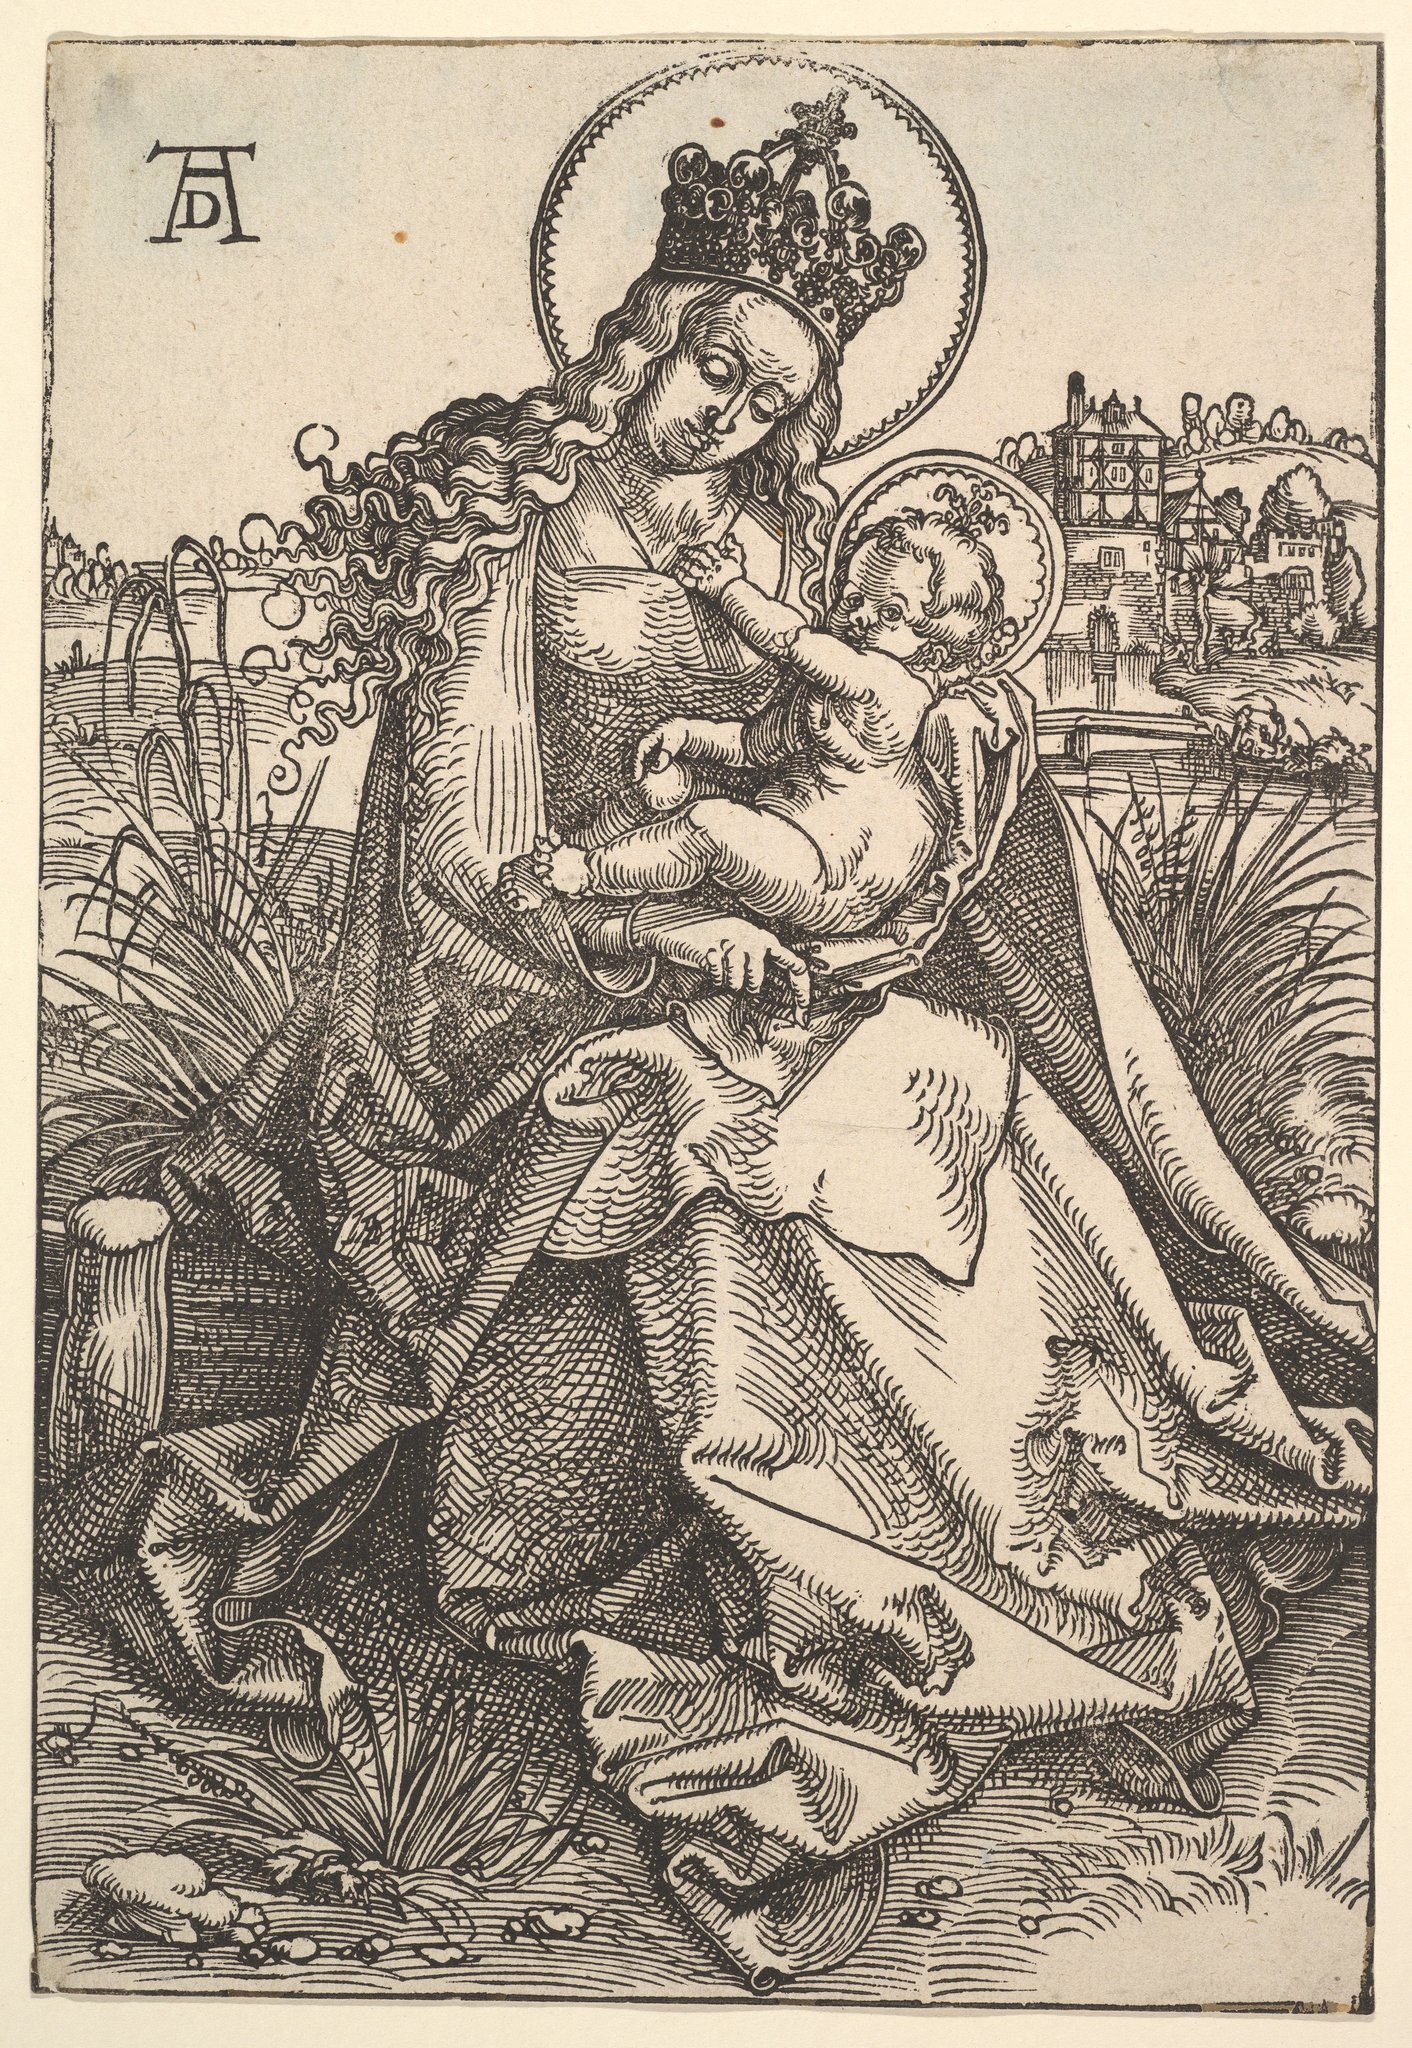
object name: print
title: The Virgin on the Grassy Bank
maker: hans baldung (called hans baldung grien)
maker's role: artist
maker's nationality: german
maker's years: 1484-1545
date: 1505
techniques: woodcut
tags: madonna and child